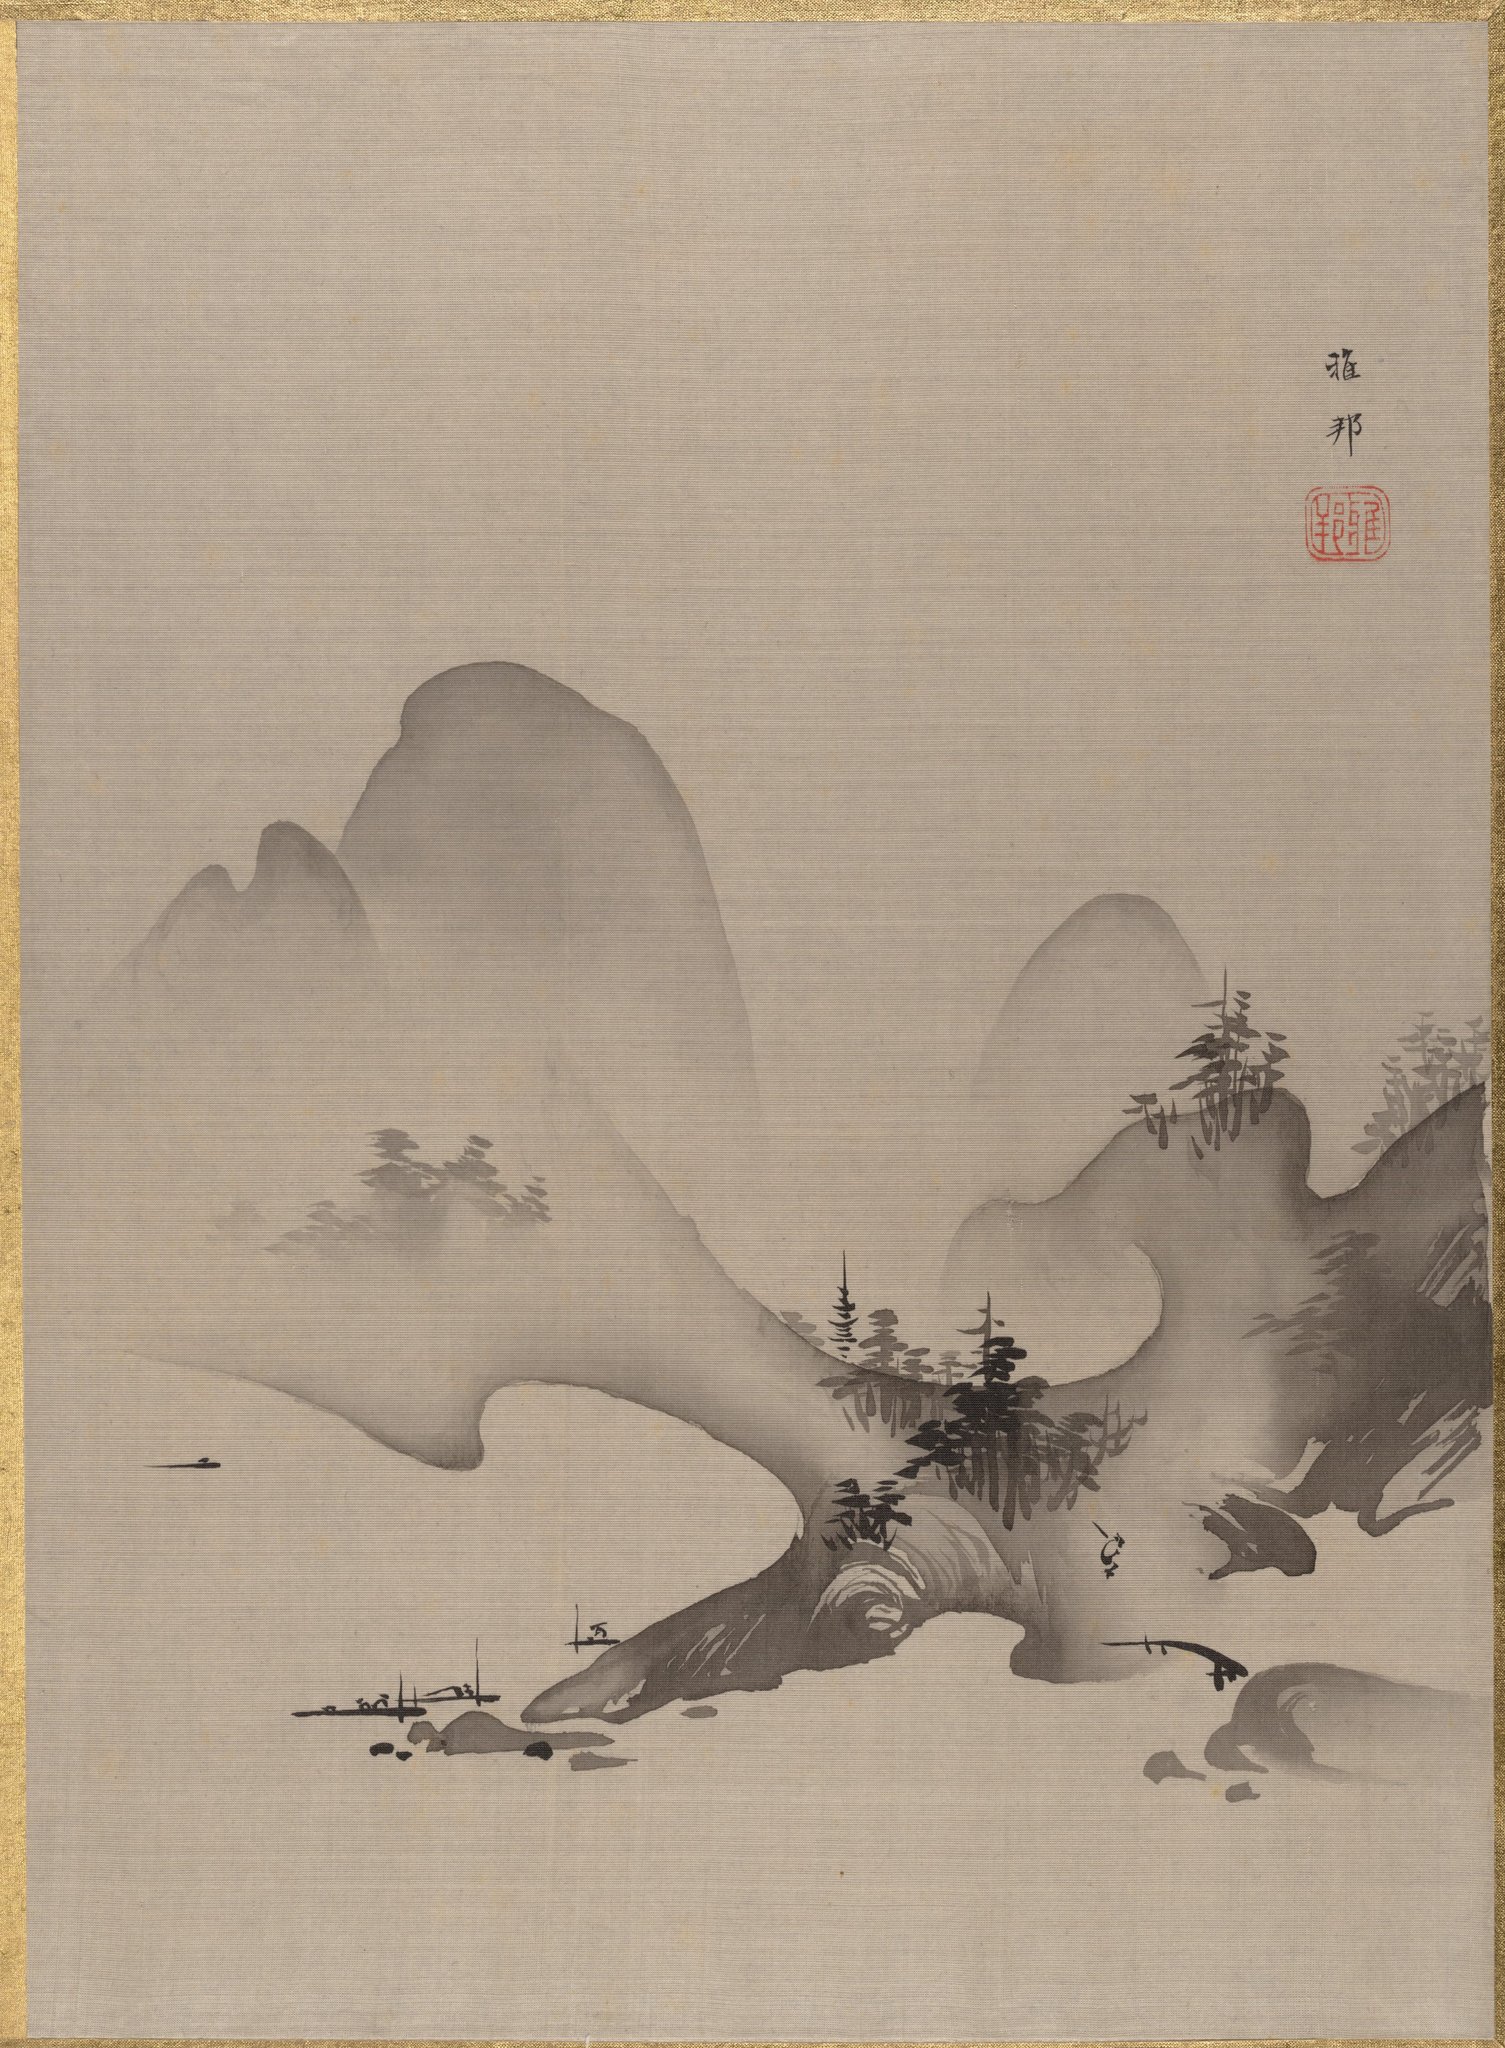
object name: album leaf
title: Lake and Mountains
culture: japanese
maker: hashimoto gahō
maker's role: artist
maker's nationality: japanese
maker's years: 1835-1908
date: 1885-1889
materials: ink, silk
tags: lakes,mountains,landscapes